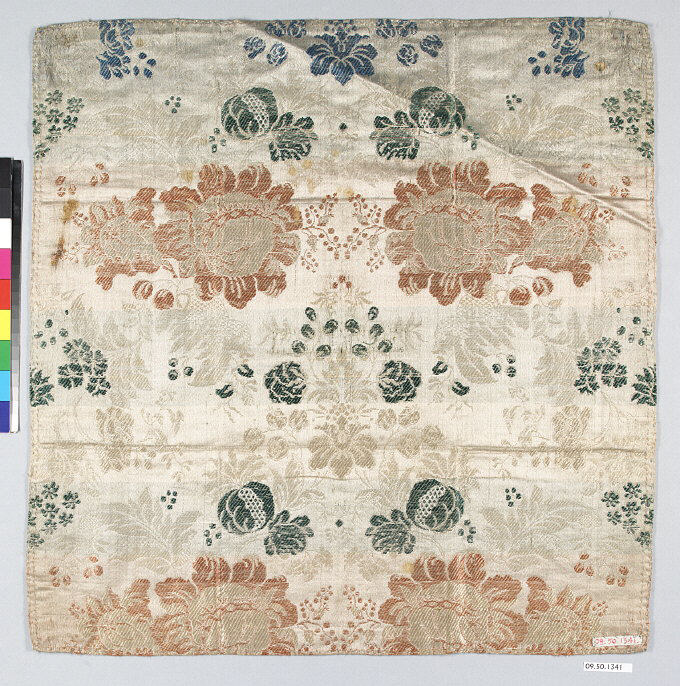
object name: piece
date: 1734-1766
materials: silk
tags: flowers,leaves